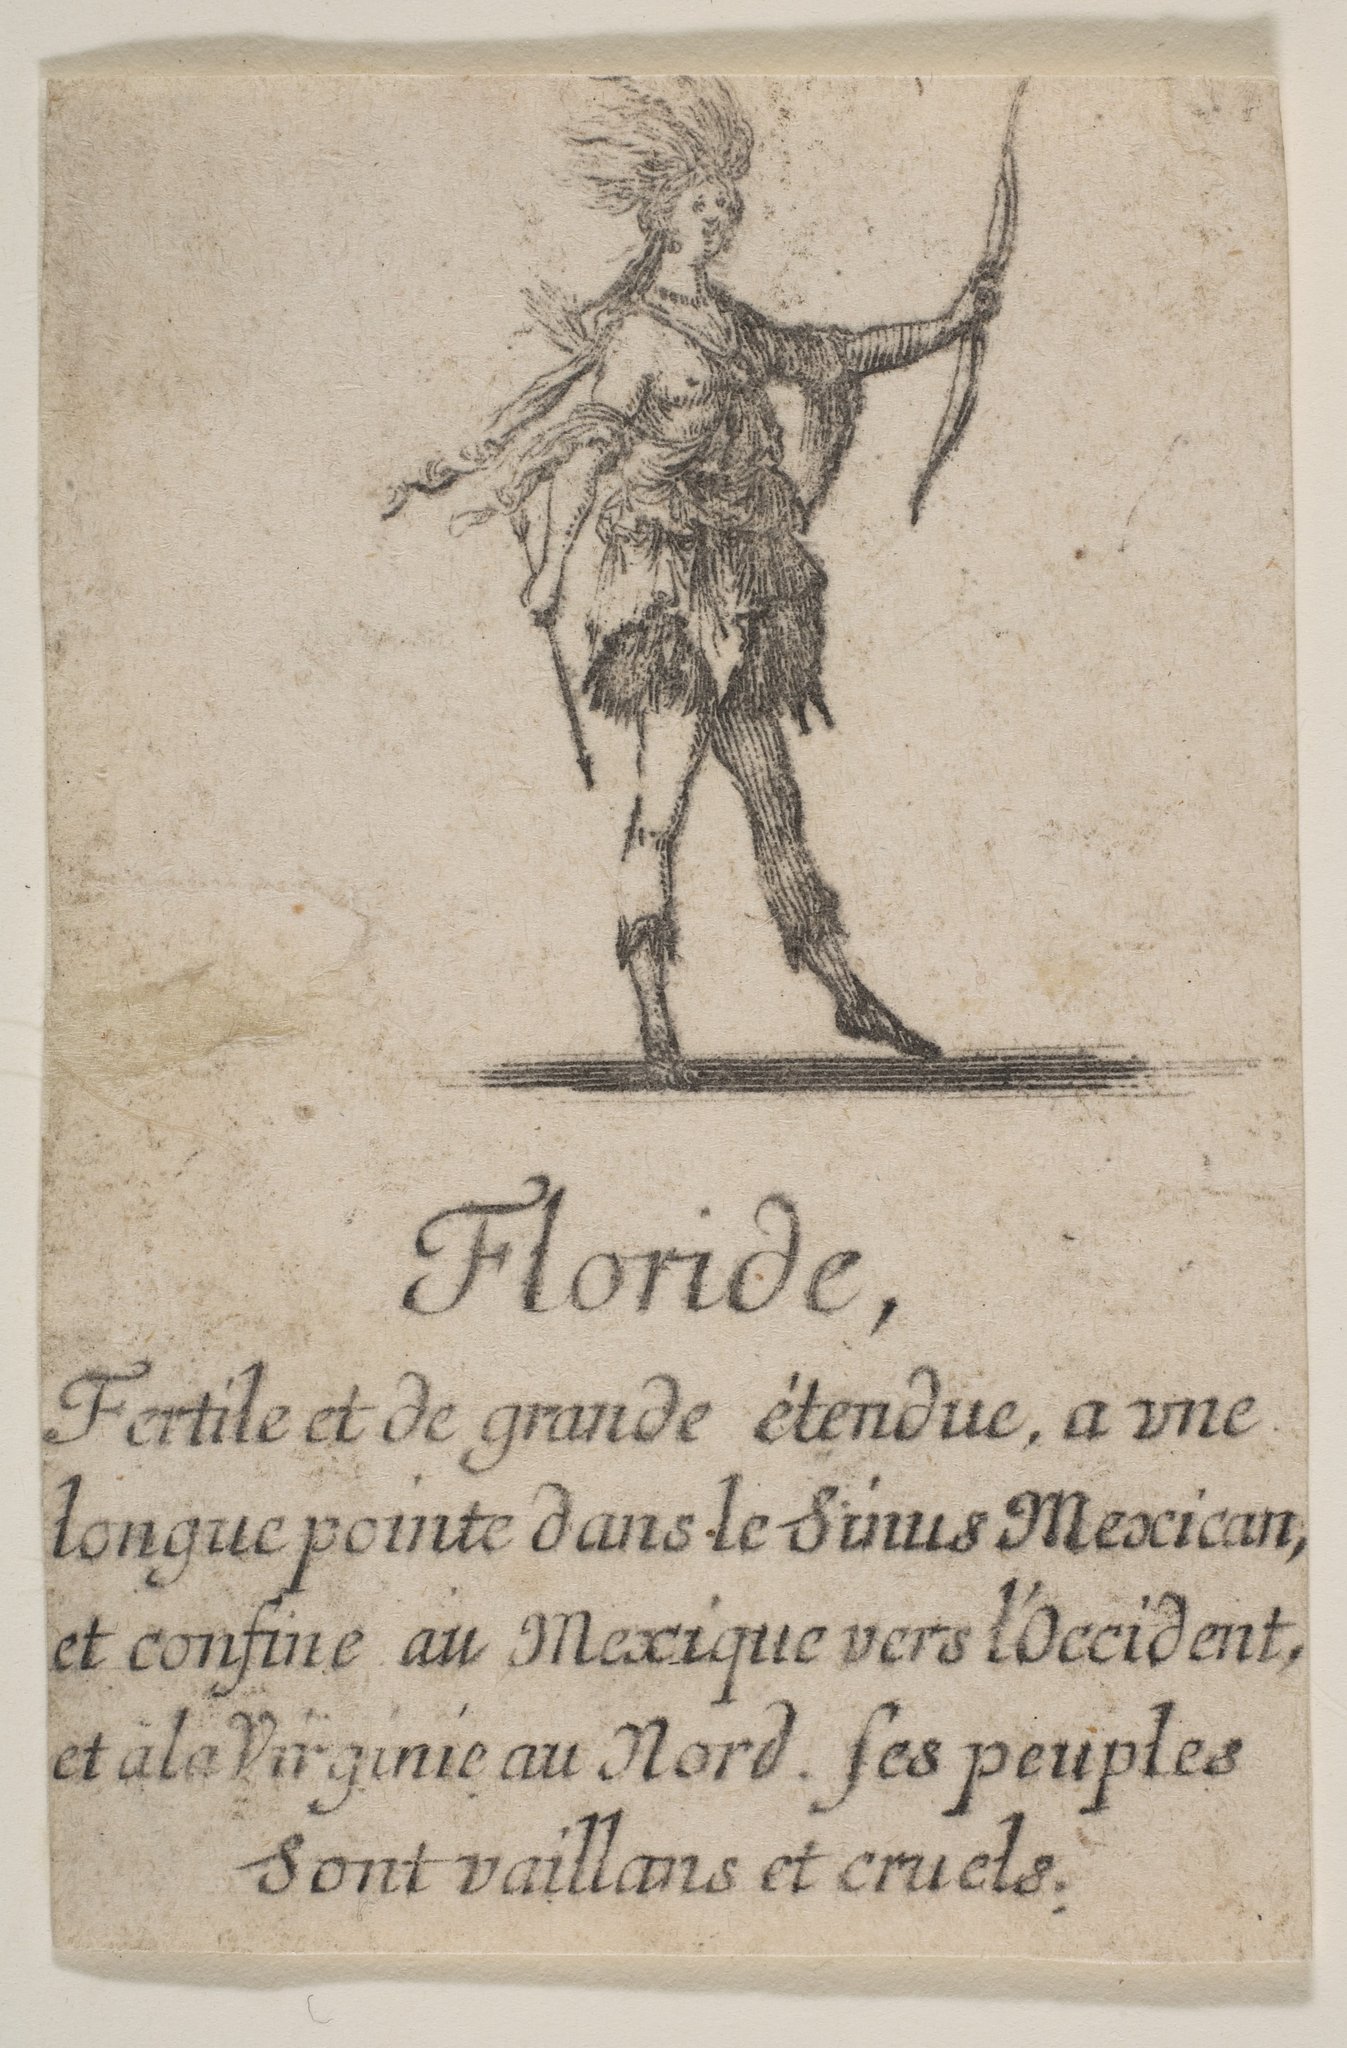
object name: print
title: Floride, from the playing cards "Jeu de la Géographie"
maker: stefano della bella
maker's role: artist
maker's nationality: italian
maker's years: 1610-1664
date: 1644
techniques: etching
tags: human figures,bow and arrow